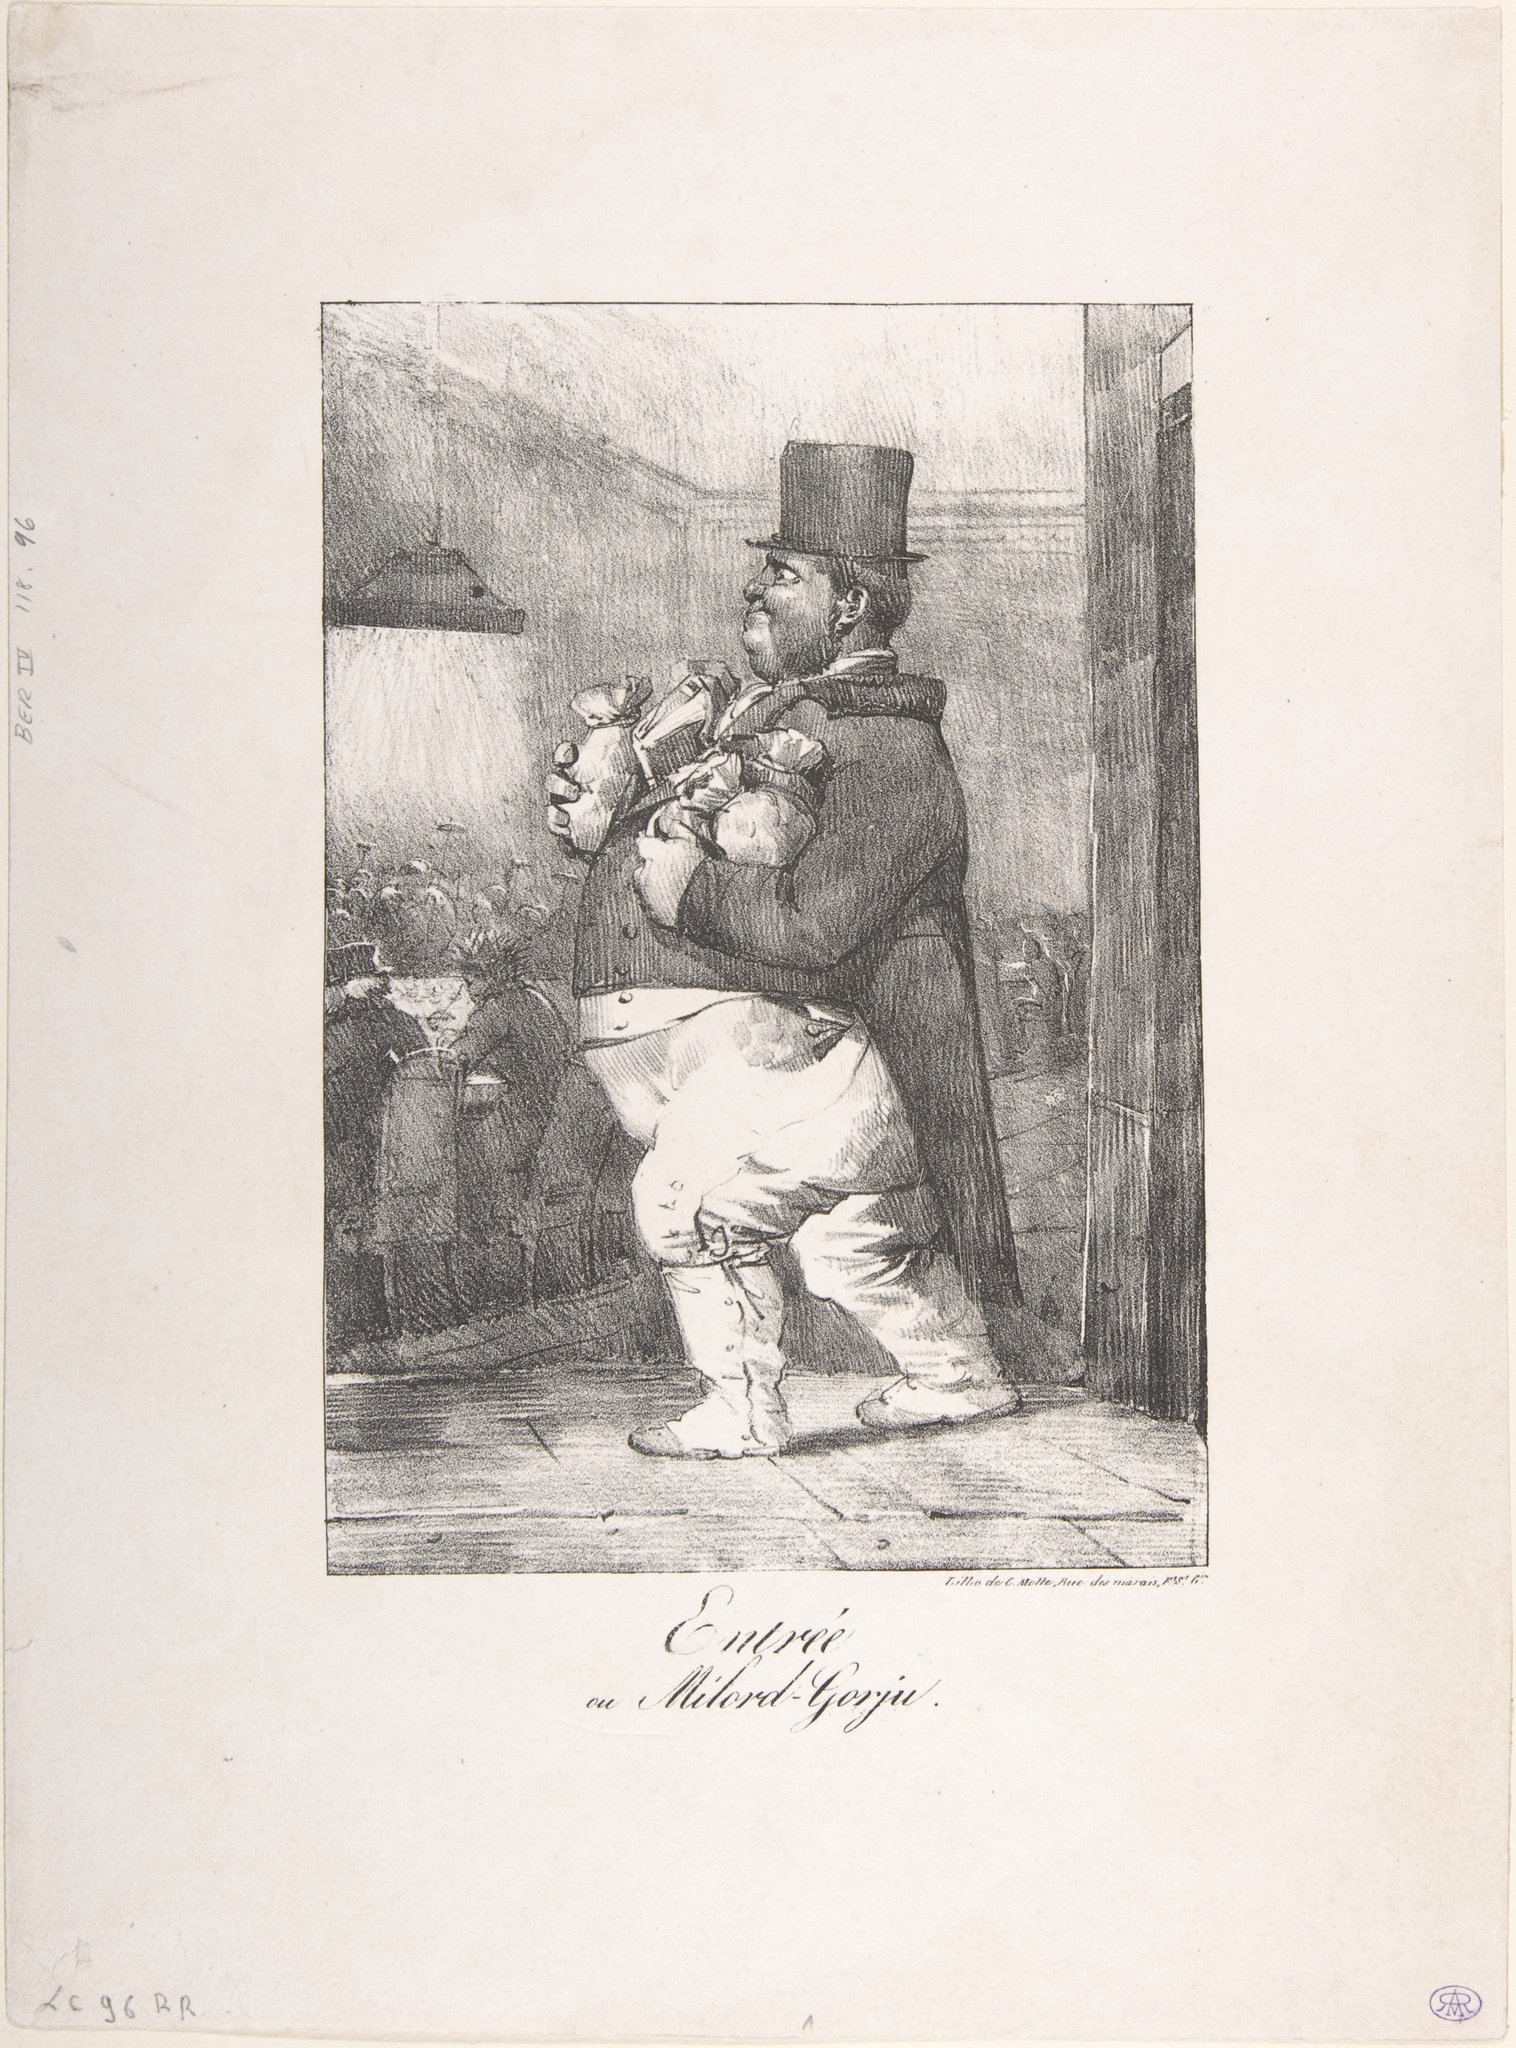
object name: print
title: Entry, or Lord Fat Cheeks (Entrée, ou Milord-Gorju)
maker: nicolas-toussaint charlet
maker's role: artist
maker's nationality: french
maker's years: 1792-1845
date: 1820-1822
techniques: lithograph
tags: men